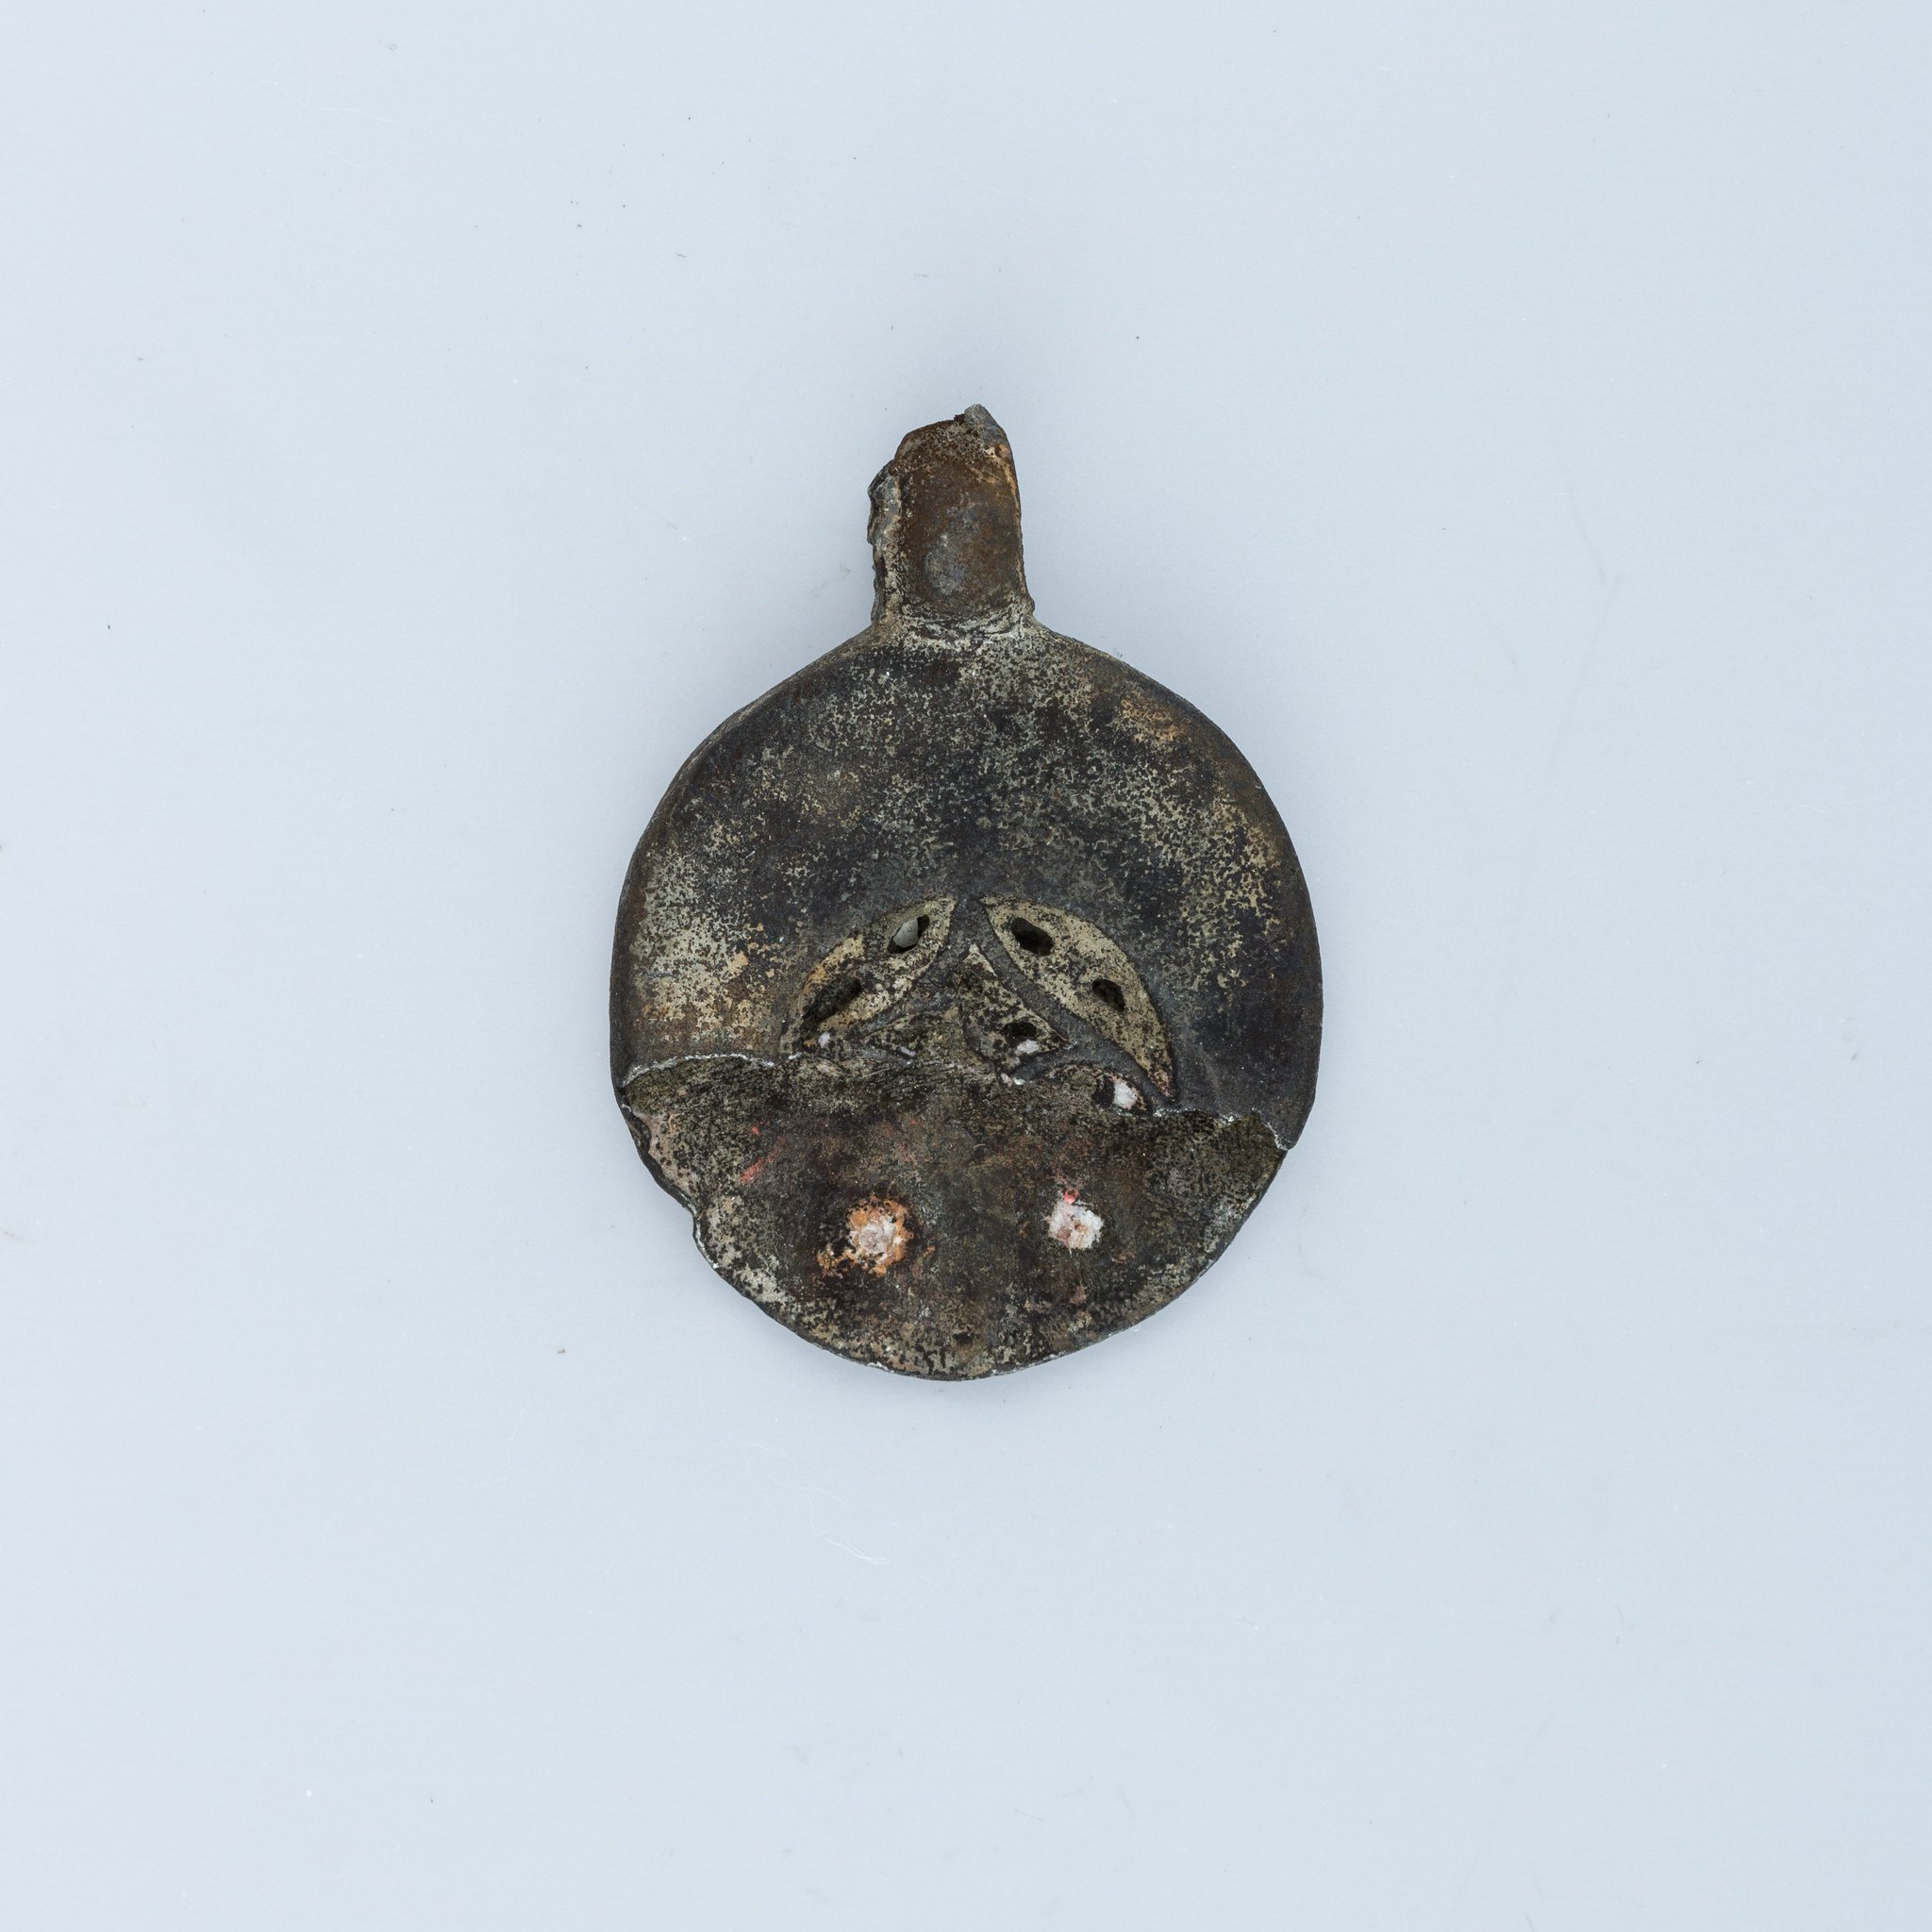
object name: strap end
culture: french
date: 1467-1533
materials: bronze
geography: france